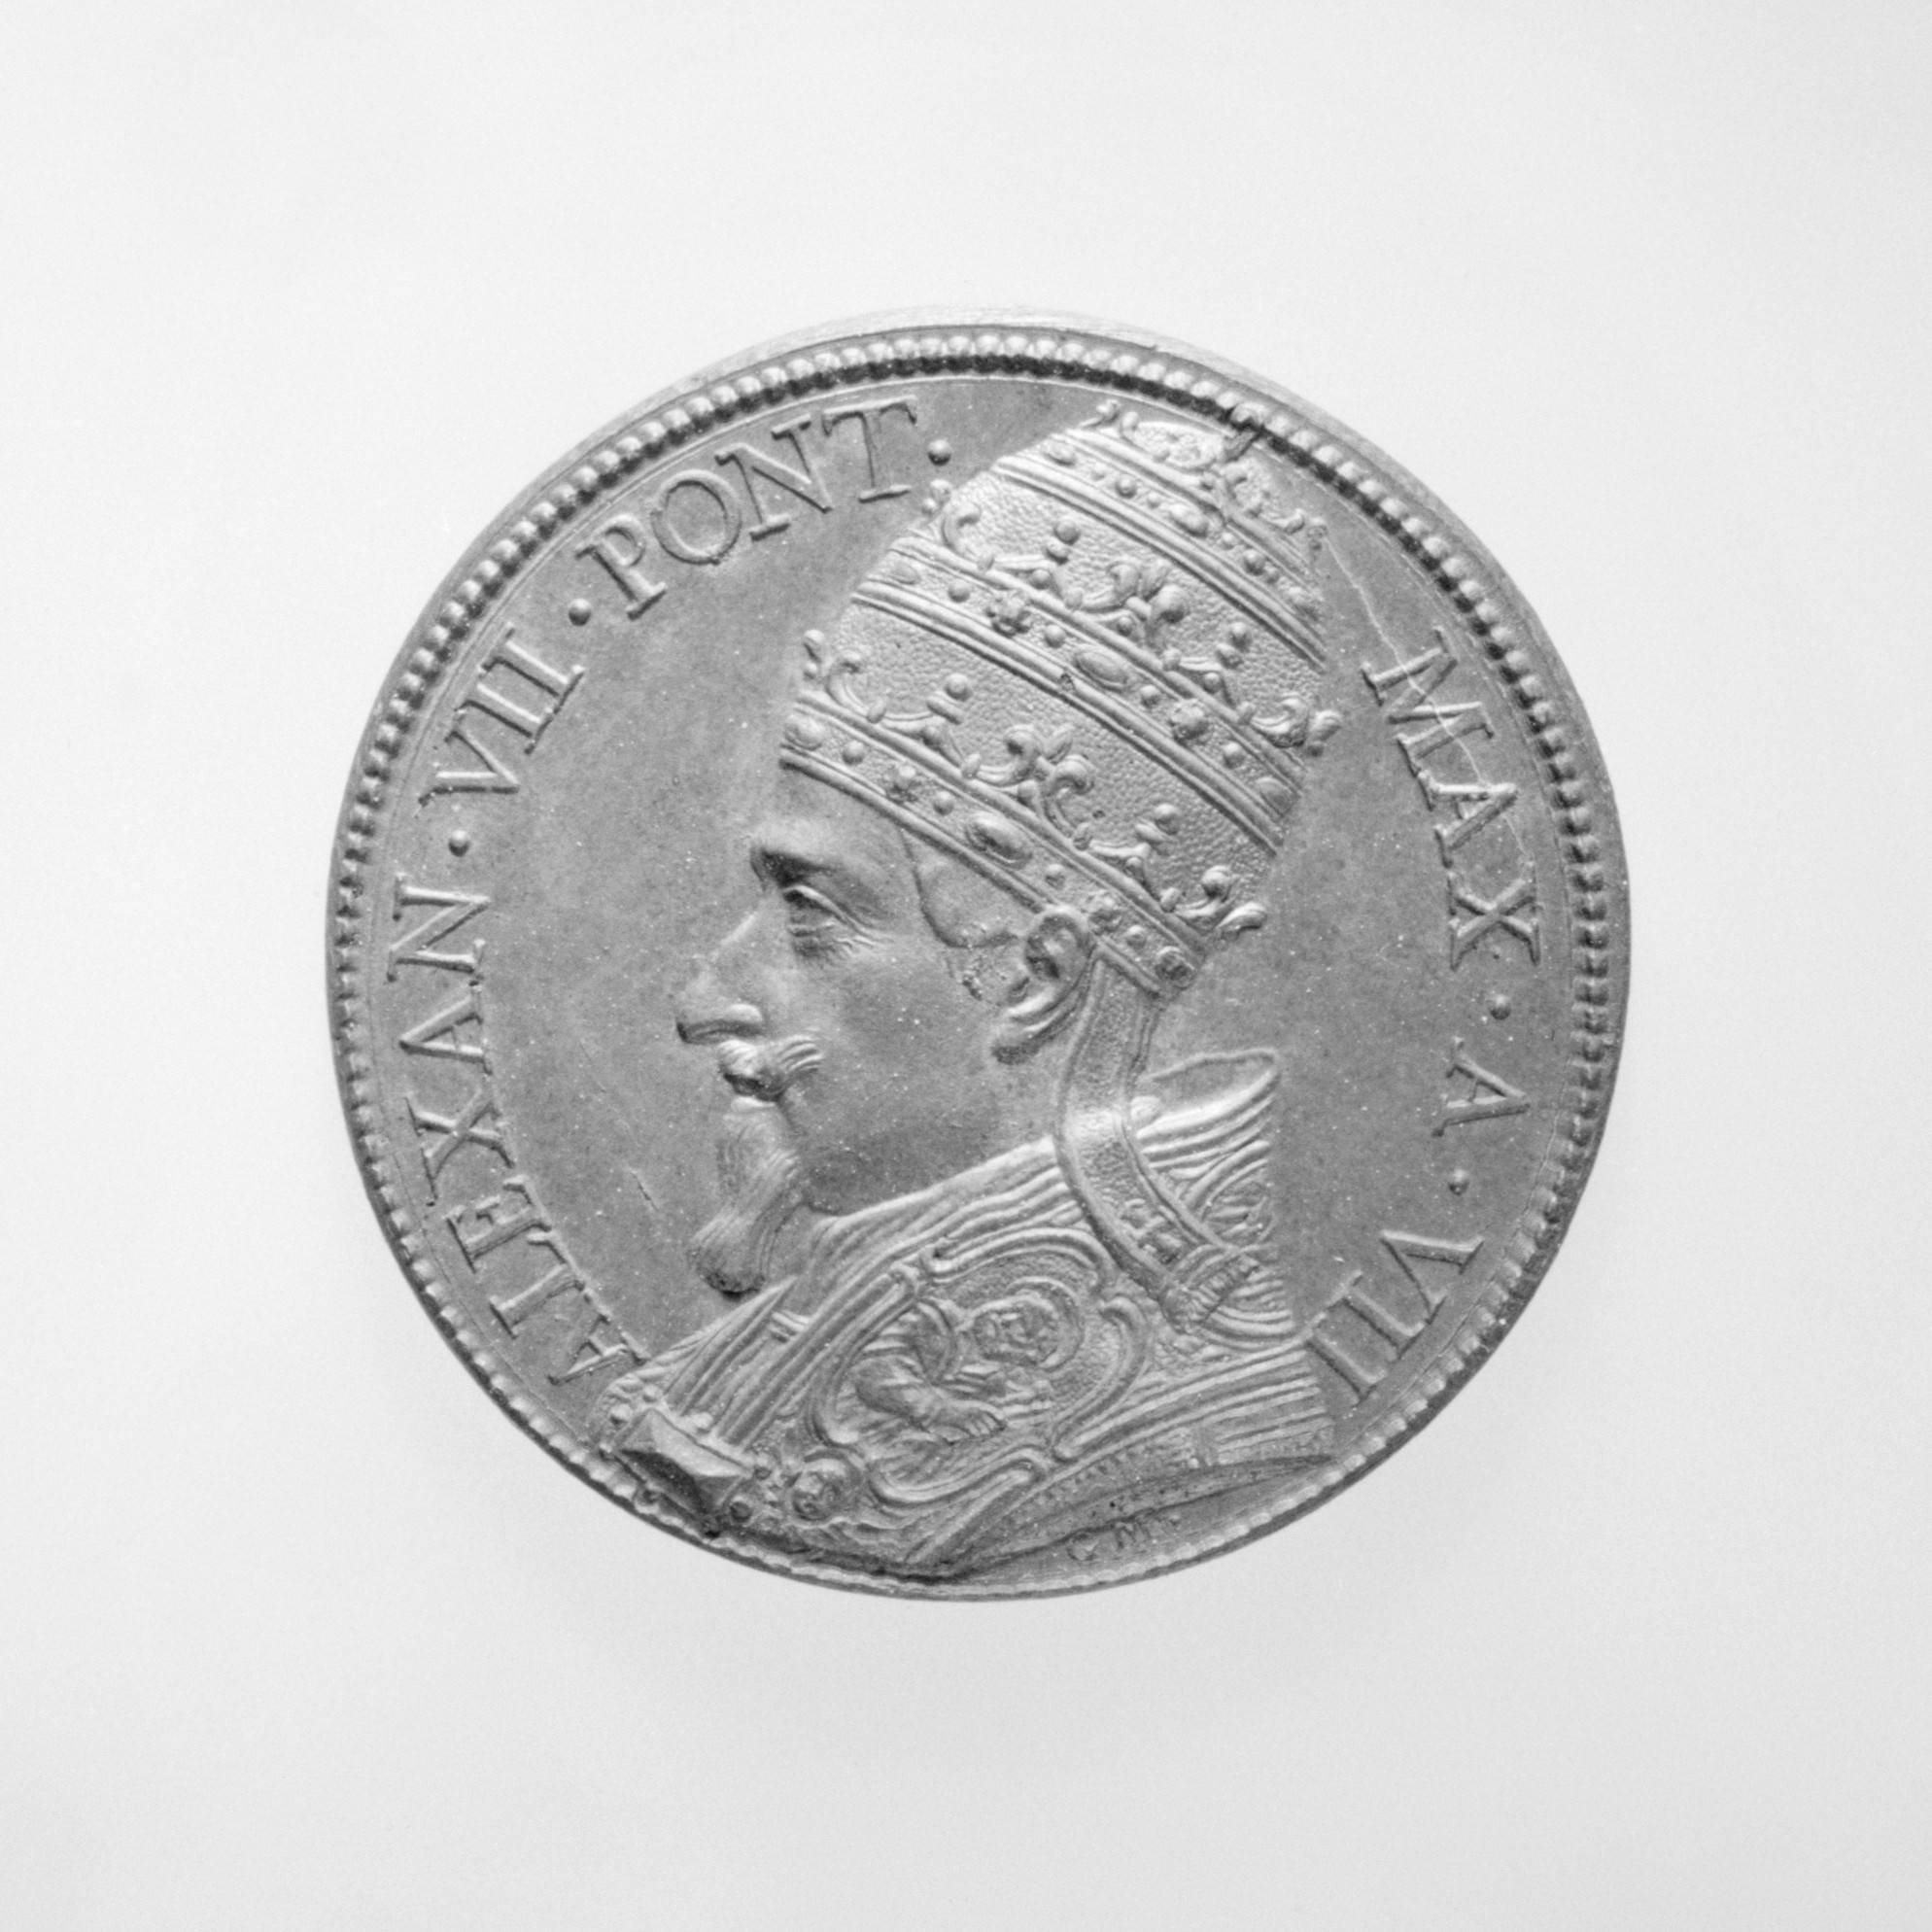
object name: medal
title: Alexander VII (Pope, 1655–67)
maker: gasparo morone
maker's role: artist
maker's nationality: italian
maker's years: 1569-1669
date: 1661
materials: bronze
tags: men,profiles,popes